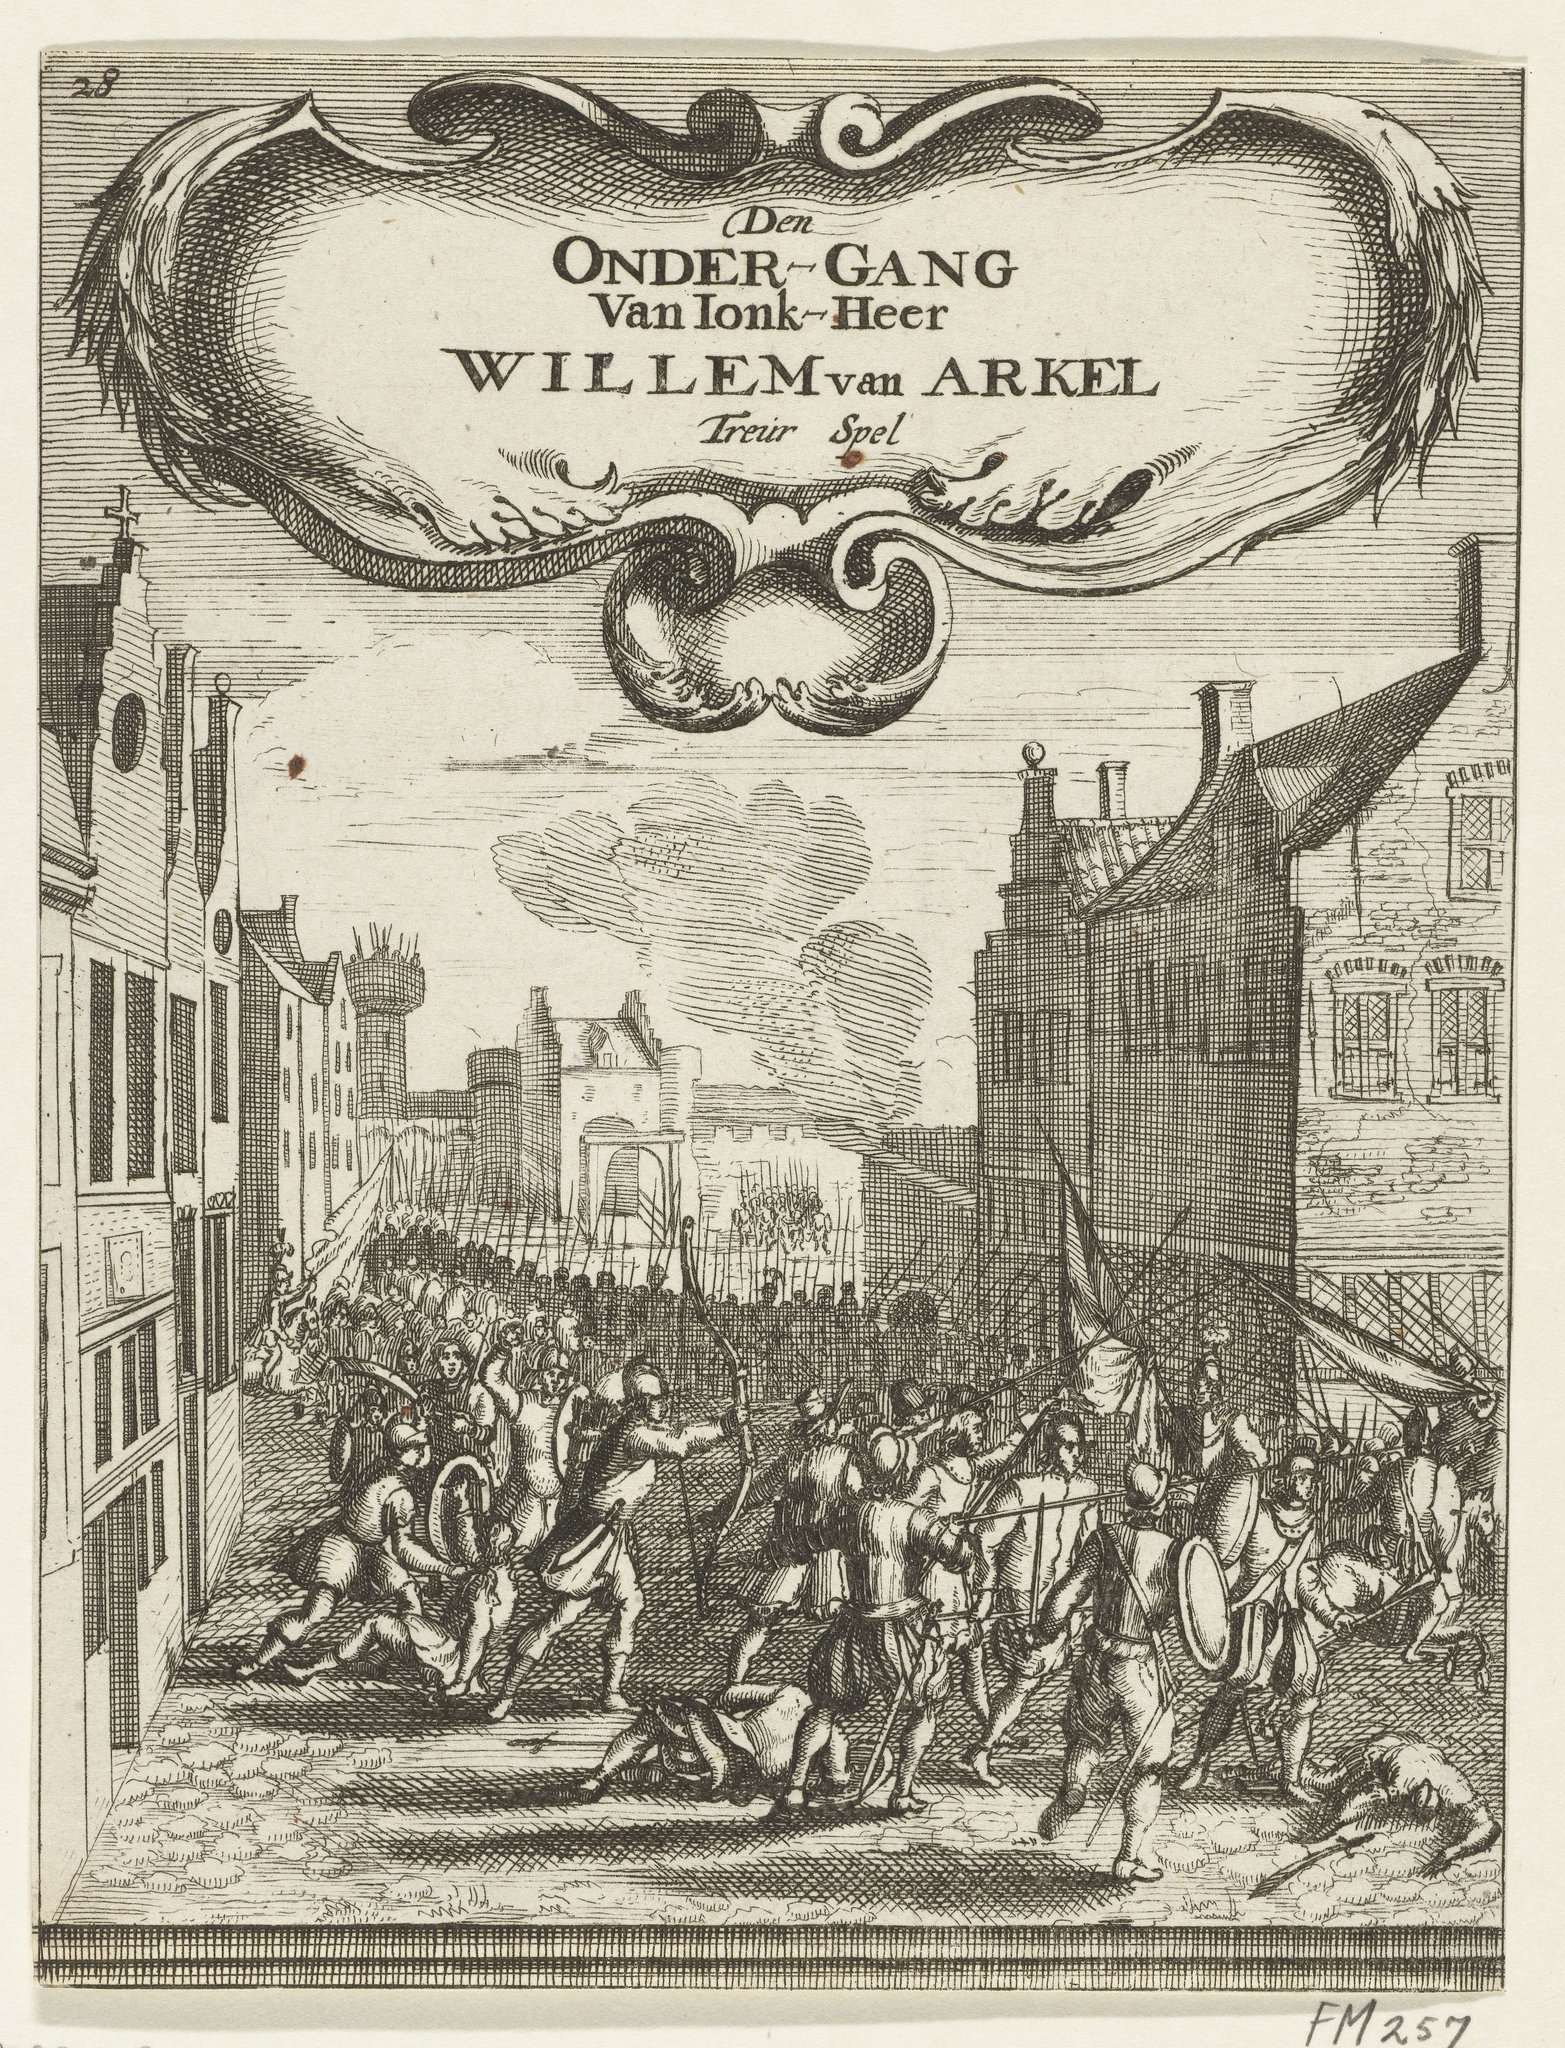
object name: print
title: Titelprent voor het treurspel Den Ondergang van Jonkheer Willem van Arkel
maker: Anonymous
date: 1660-1665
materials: paper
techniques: etching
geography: northern netherlands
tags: violent death, being killed; being mishandled and maltreated; seeking death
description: Titelprent voor het treurspel Den Ondergang van Jonkheer Willem van Arkel. Willem Heer van Arkel sneuvelt tijdens een gevecht op straat in de Krijtsteeg te Gorinchem, 1 december 1417.